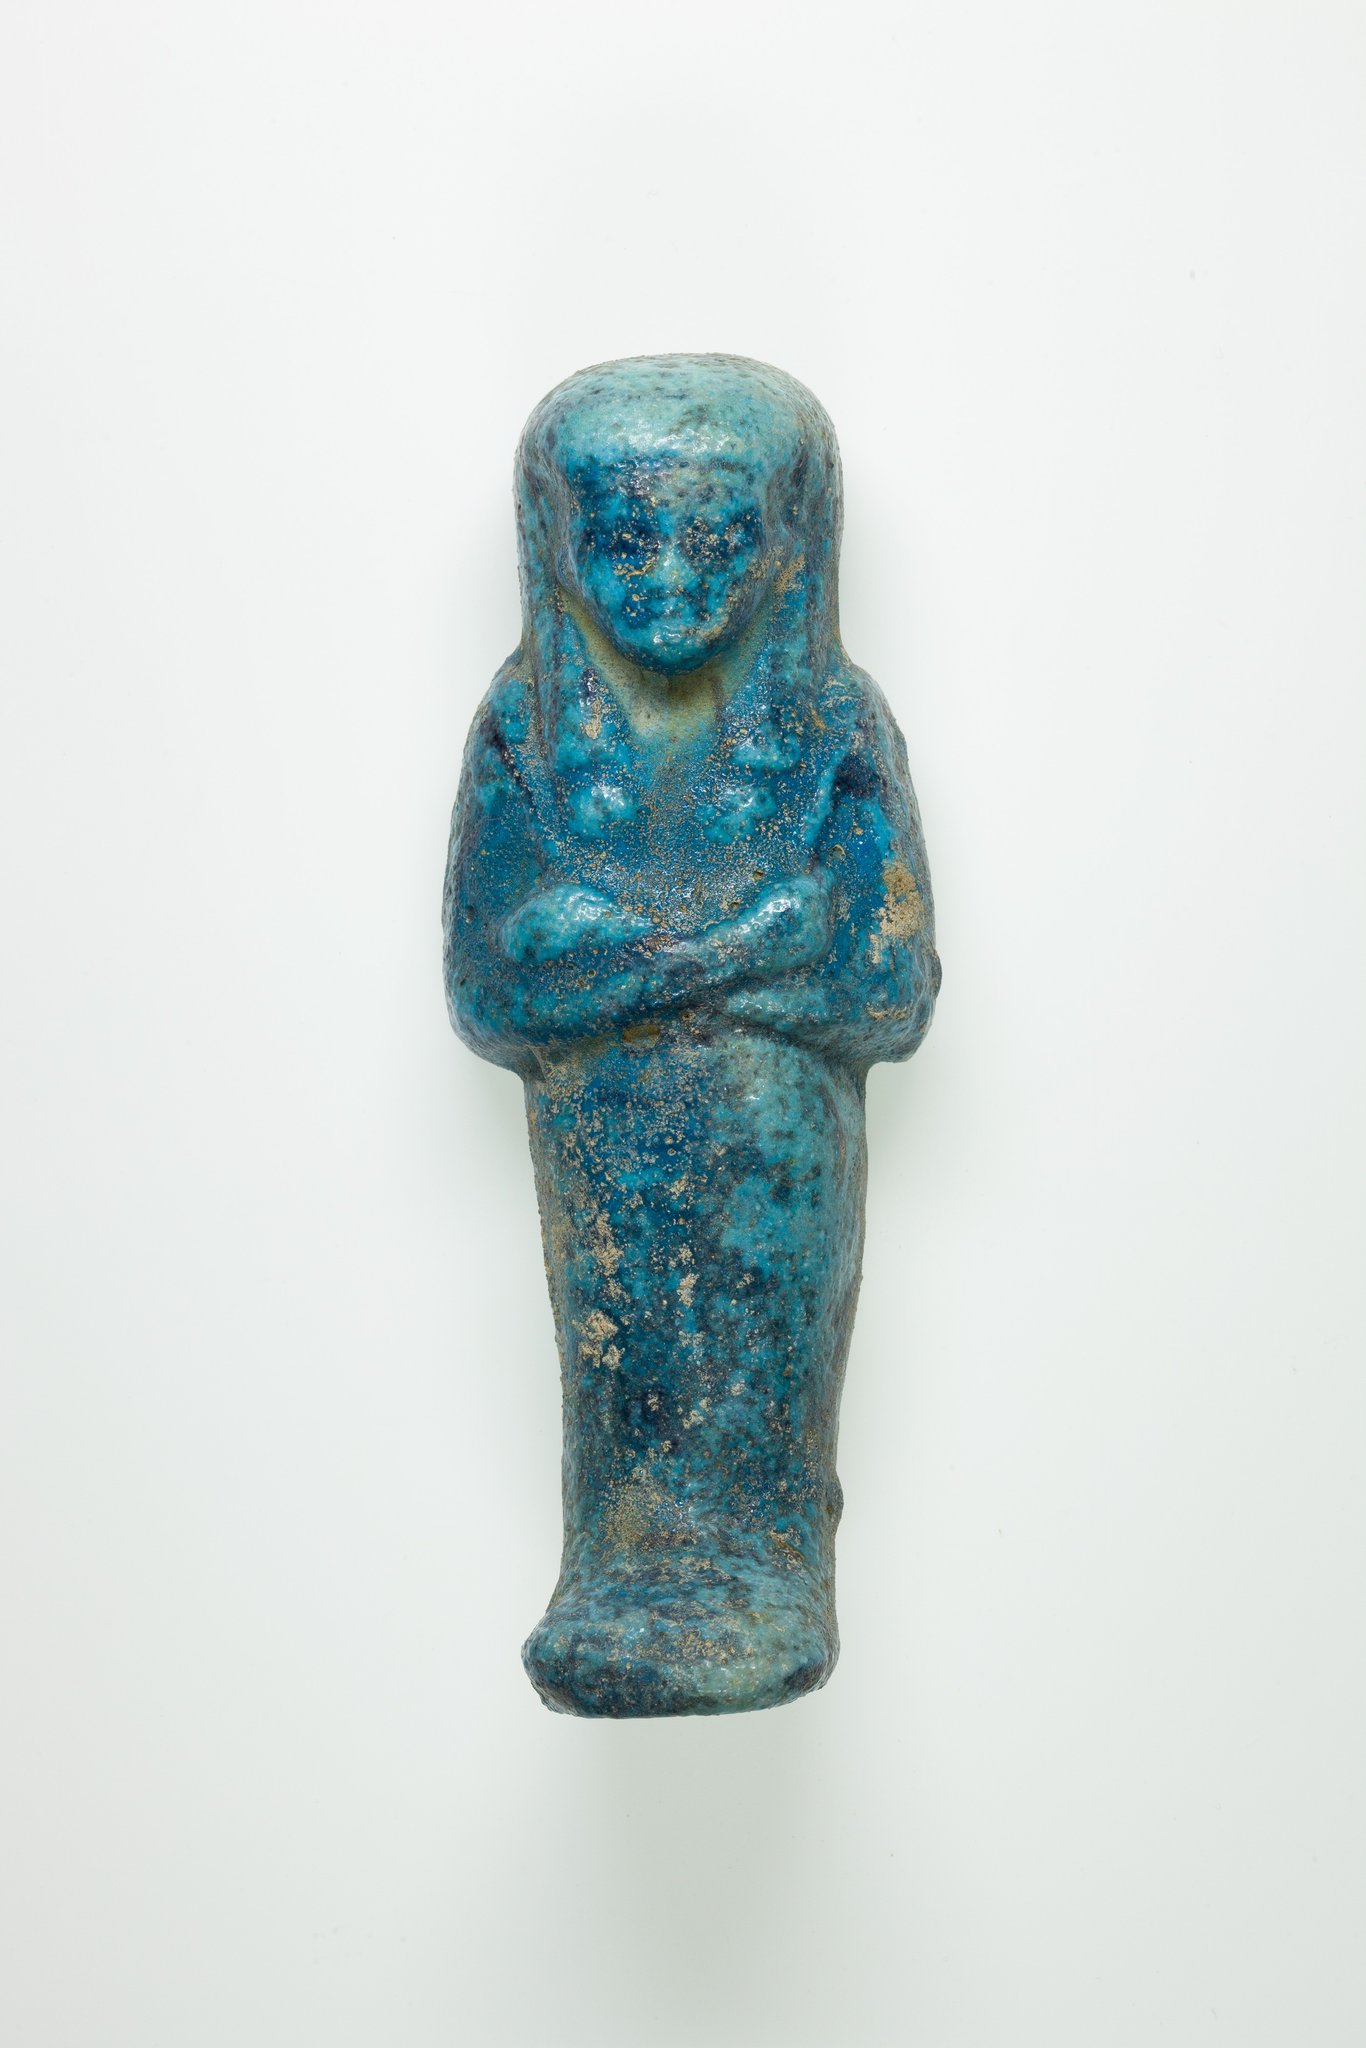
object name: worker shabti, henettawy c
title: Worker Shabti of Henettawy (C), Daughter of Isetemkheb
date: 990-970 BCE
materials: faience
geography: egypt